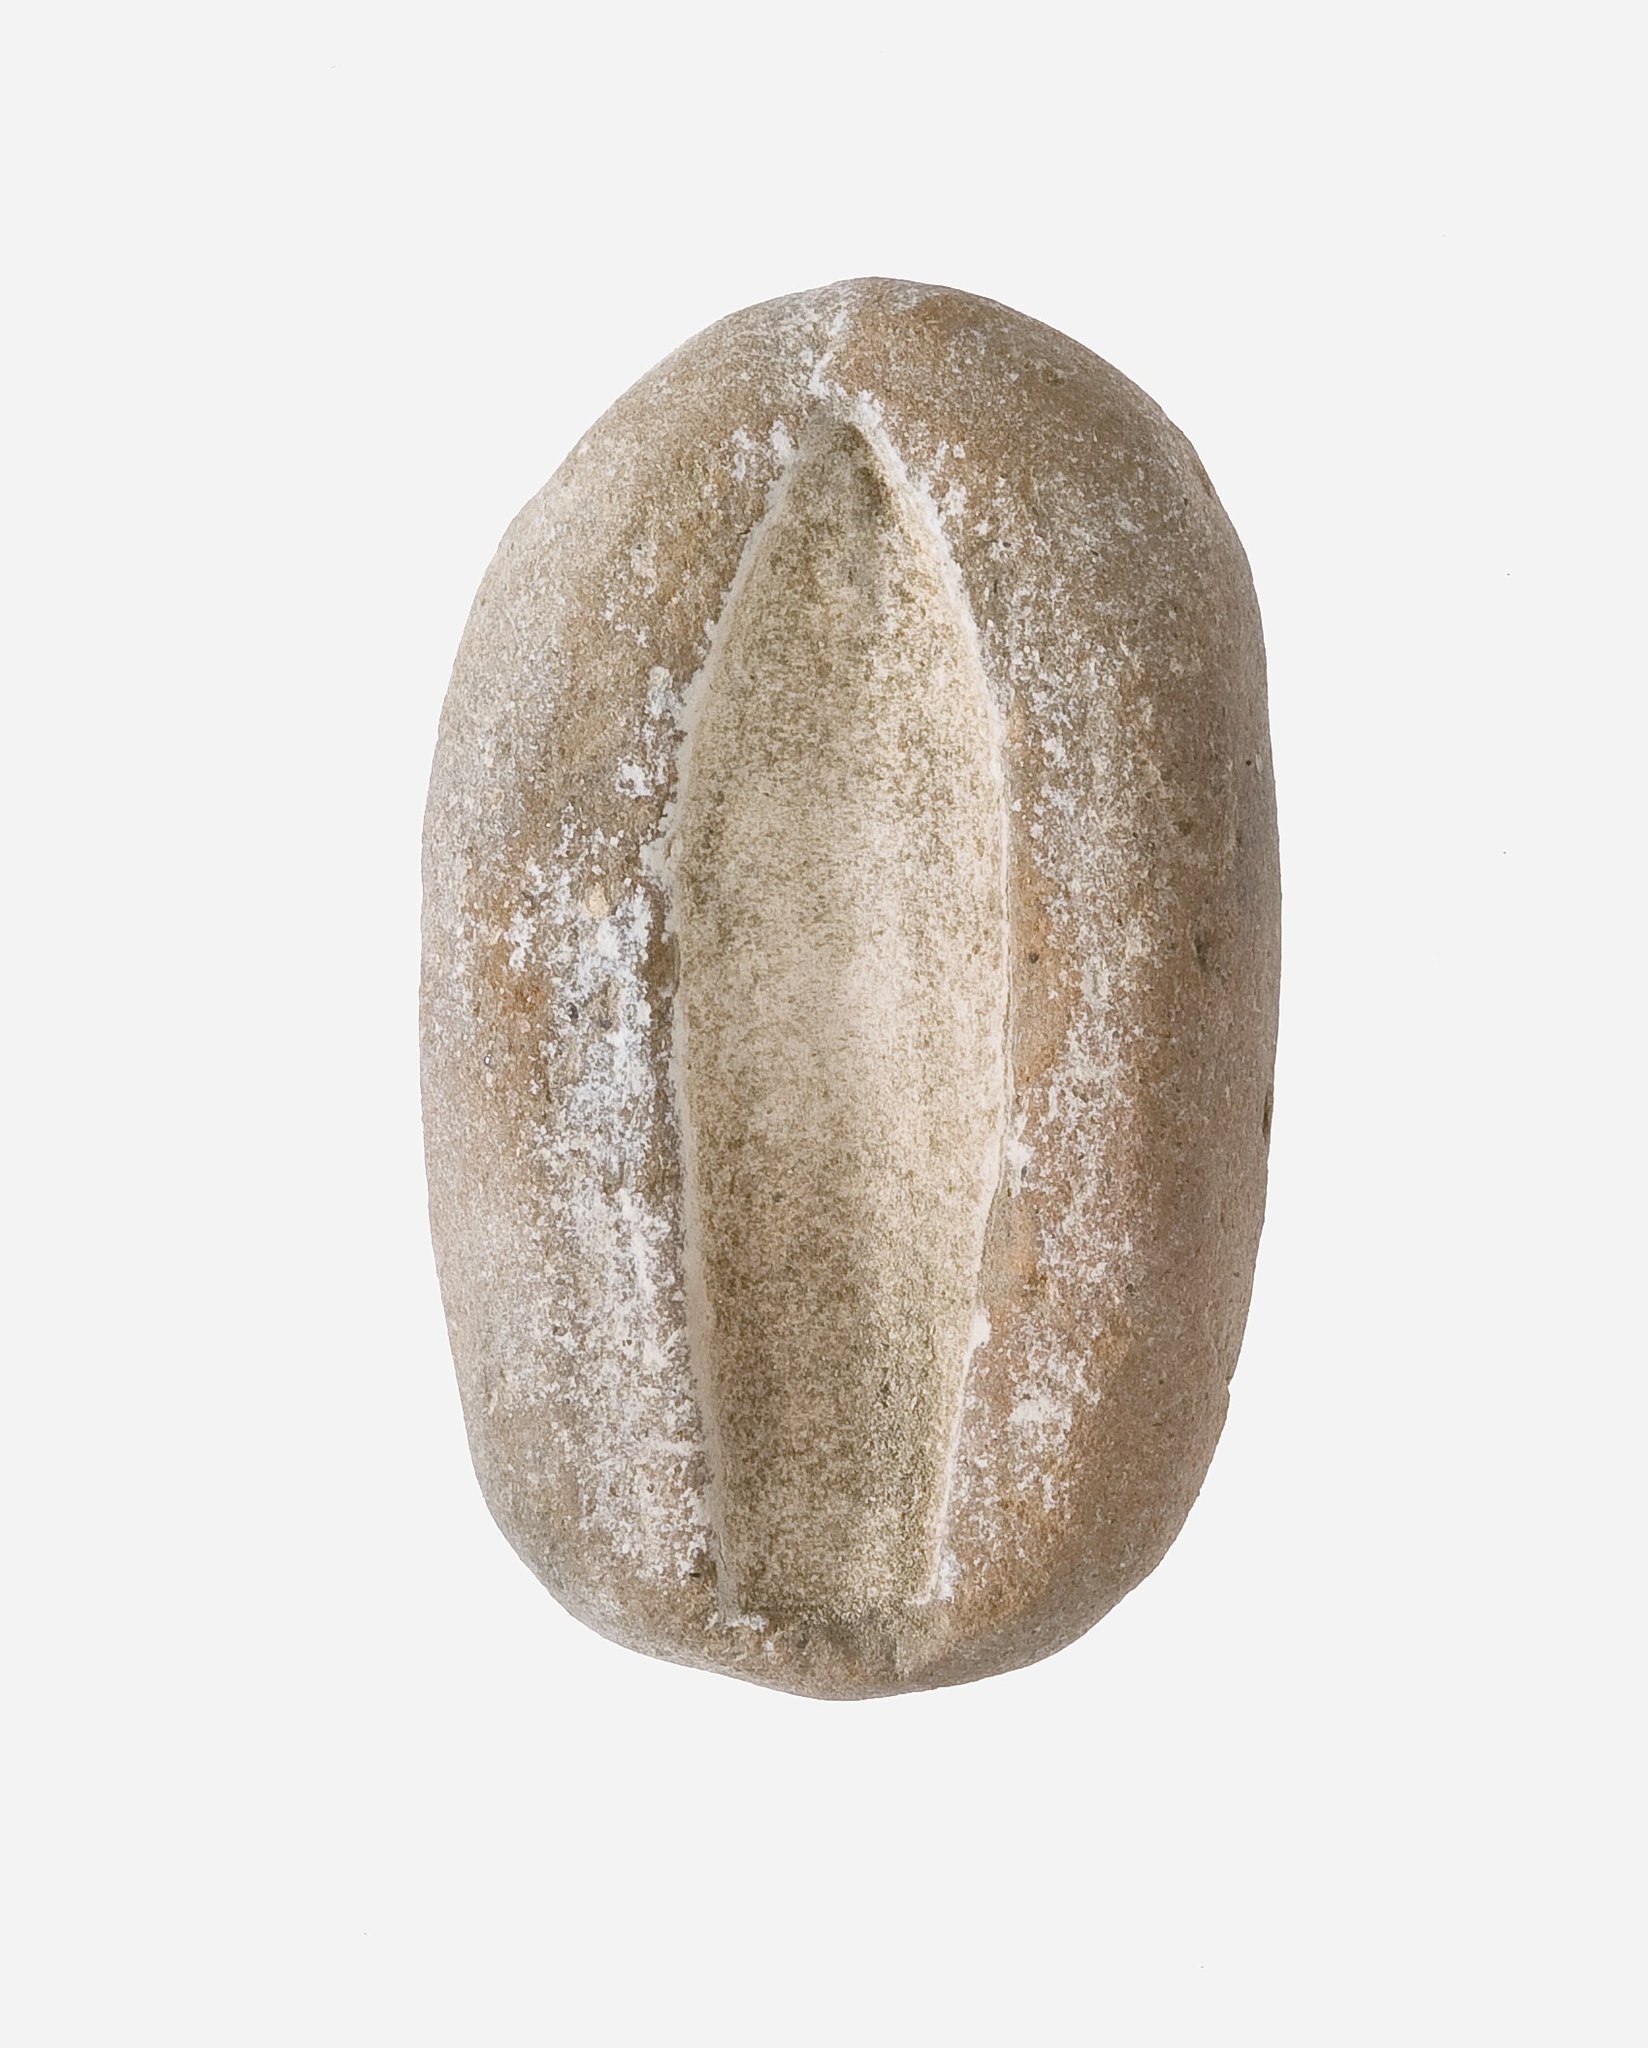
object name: mold, bead, lily petal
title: Mold of a Lily Petal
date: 1390-1352 BCE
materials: pottery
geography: egypt